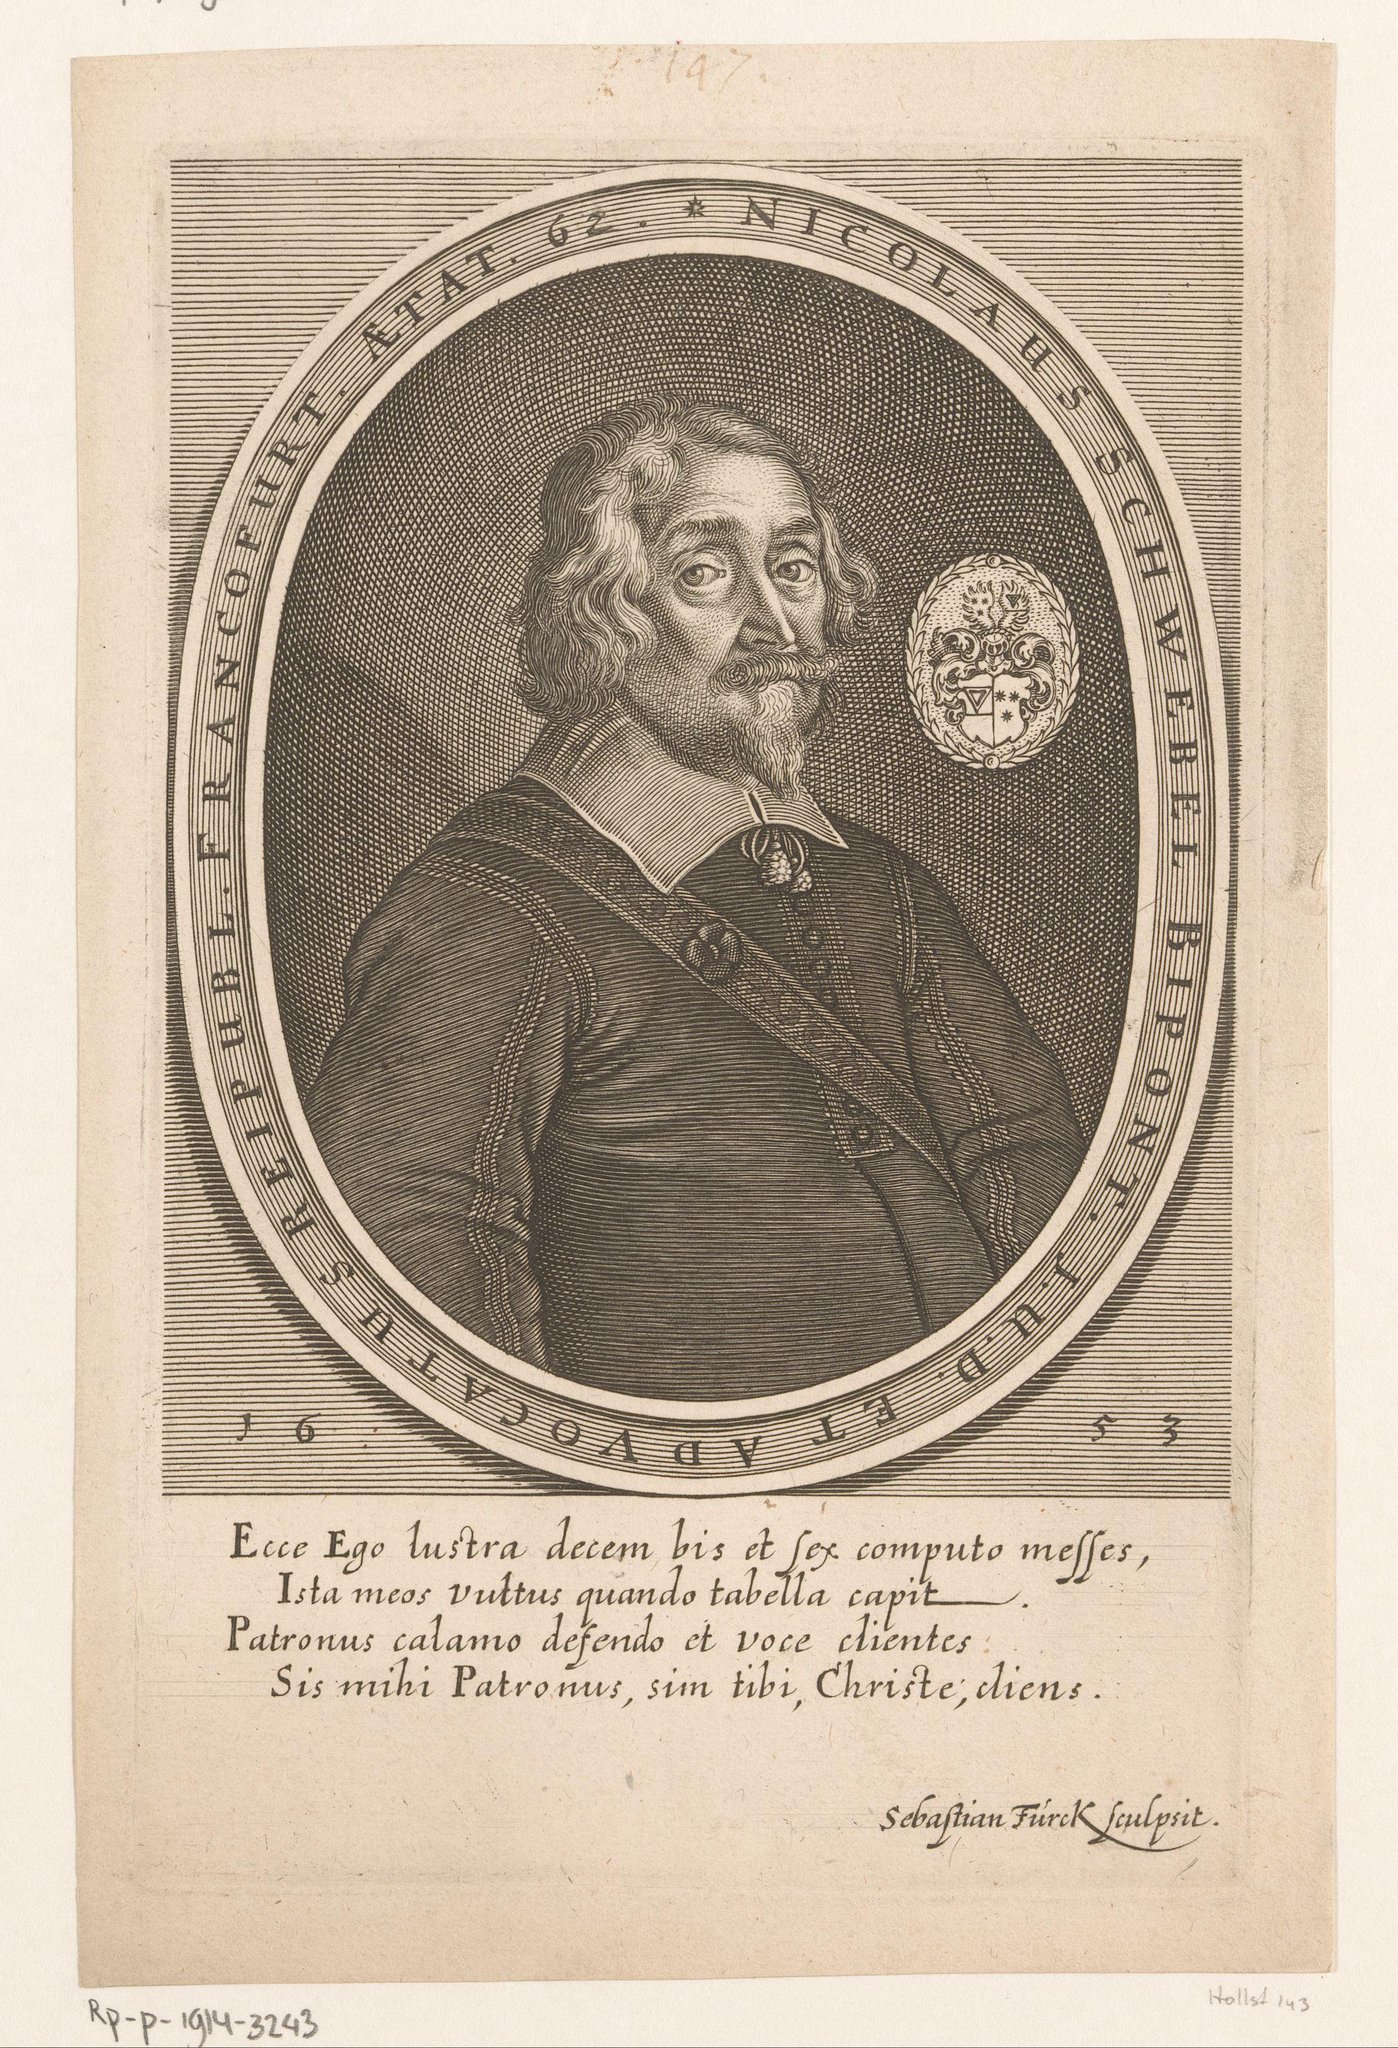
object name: print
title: Portret van Nikolaus Schwebel op 62-jarige leeftijd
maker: sebastian furck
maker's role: print maker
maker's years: 1600-1655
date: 1653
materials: paper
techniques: engraving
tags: historical persons, armorial bearing, heraldry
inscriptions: collector's mark: Lugt 2228